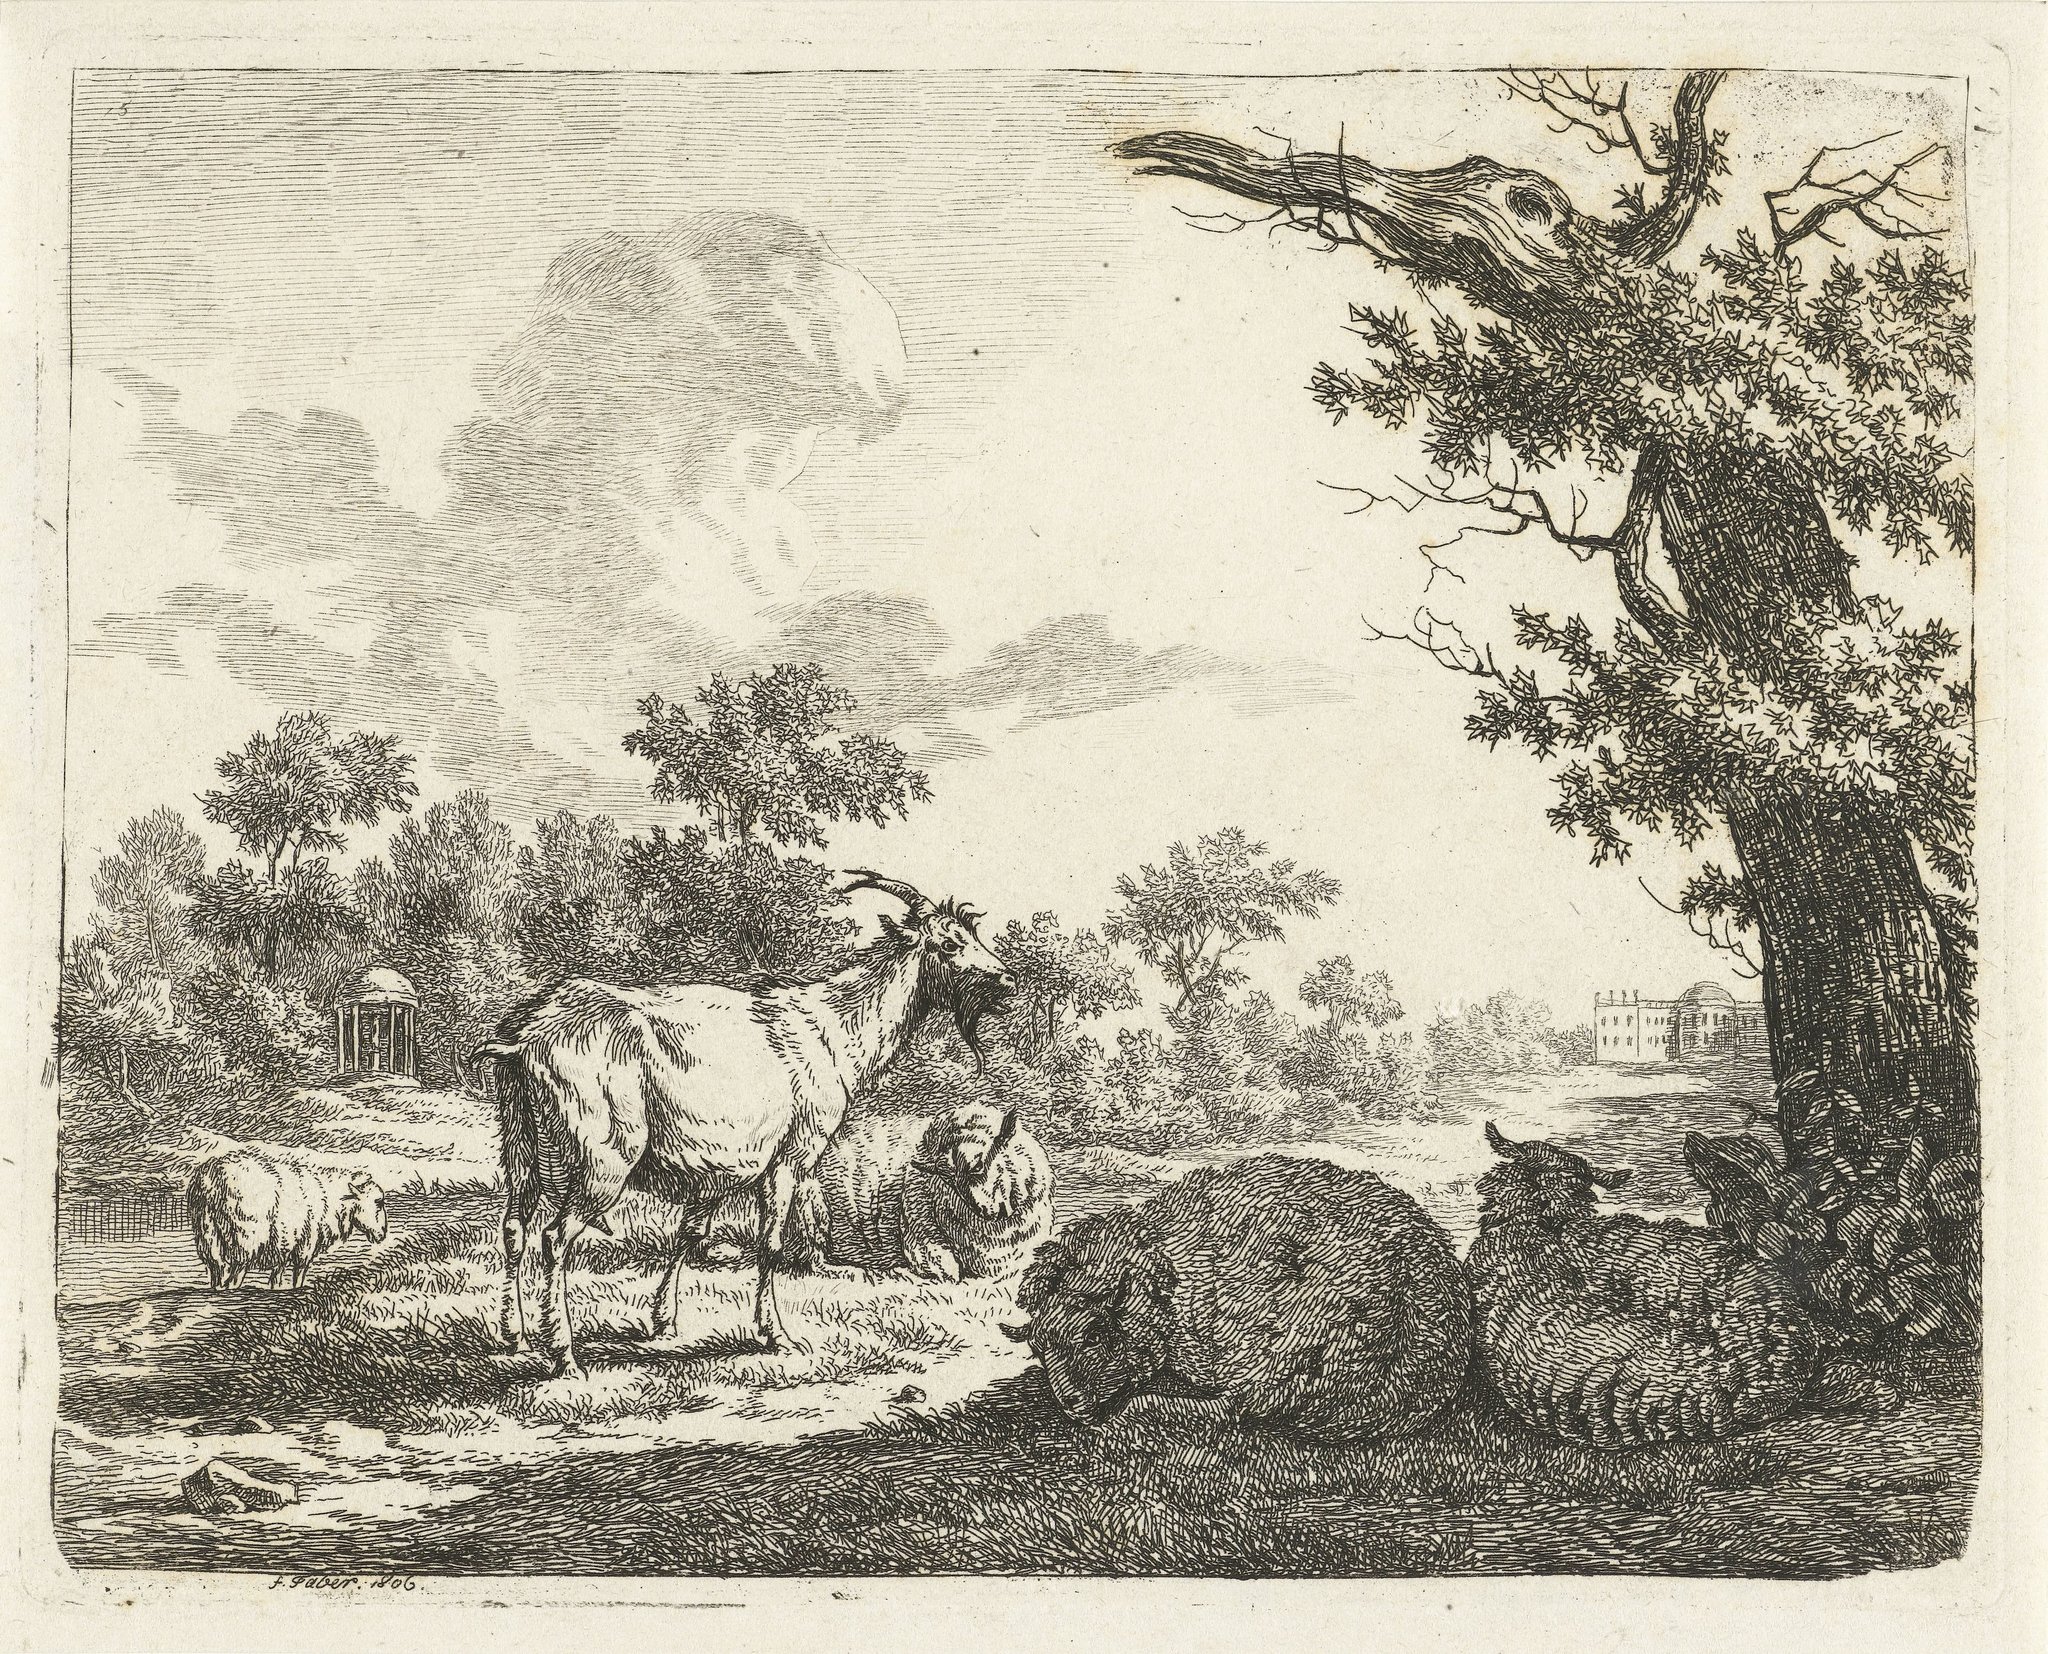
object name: print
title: Landgoed met schapen en een geit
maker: frédéric théodore faber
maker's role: print maker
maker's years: 1782-1844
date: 1806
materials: paper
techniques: etching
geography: brussels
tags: cattle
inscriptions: collector's mark: Lugt 2228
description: Een geit staat tussen vier schapen in, waarvan er twee onder een boom in de schaduw liggen. Op de achtergrond een groot landhuis.